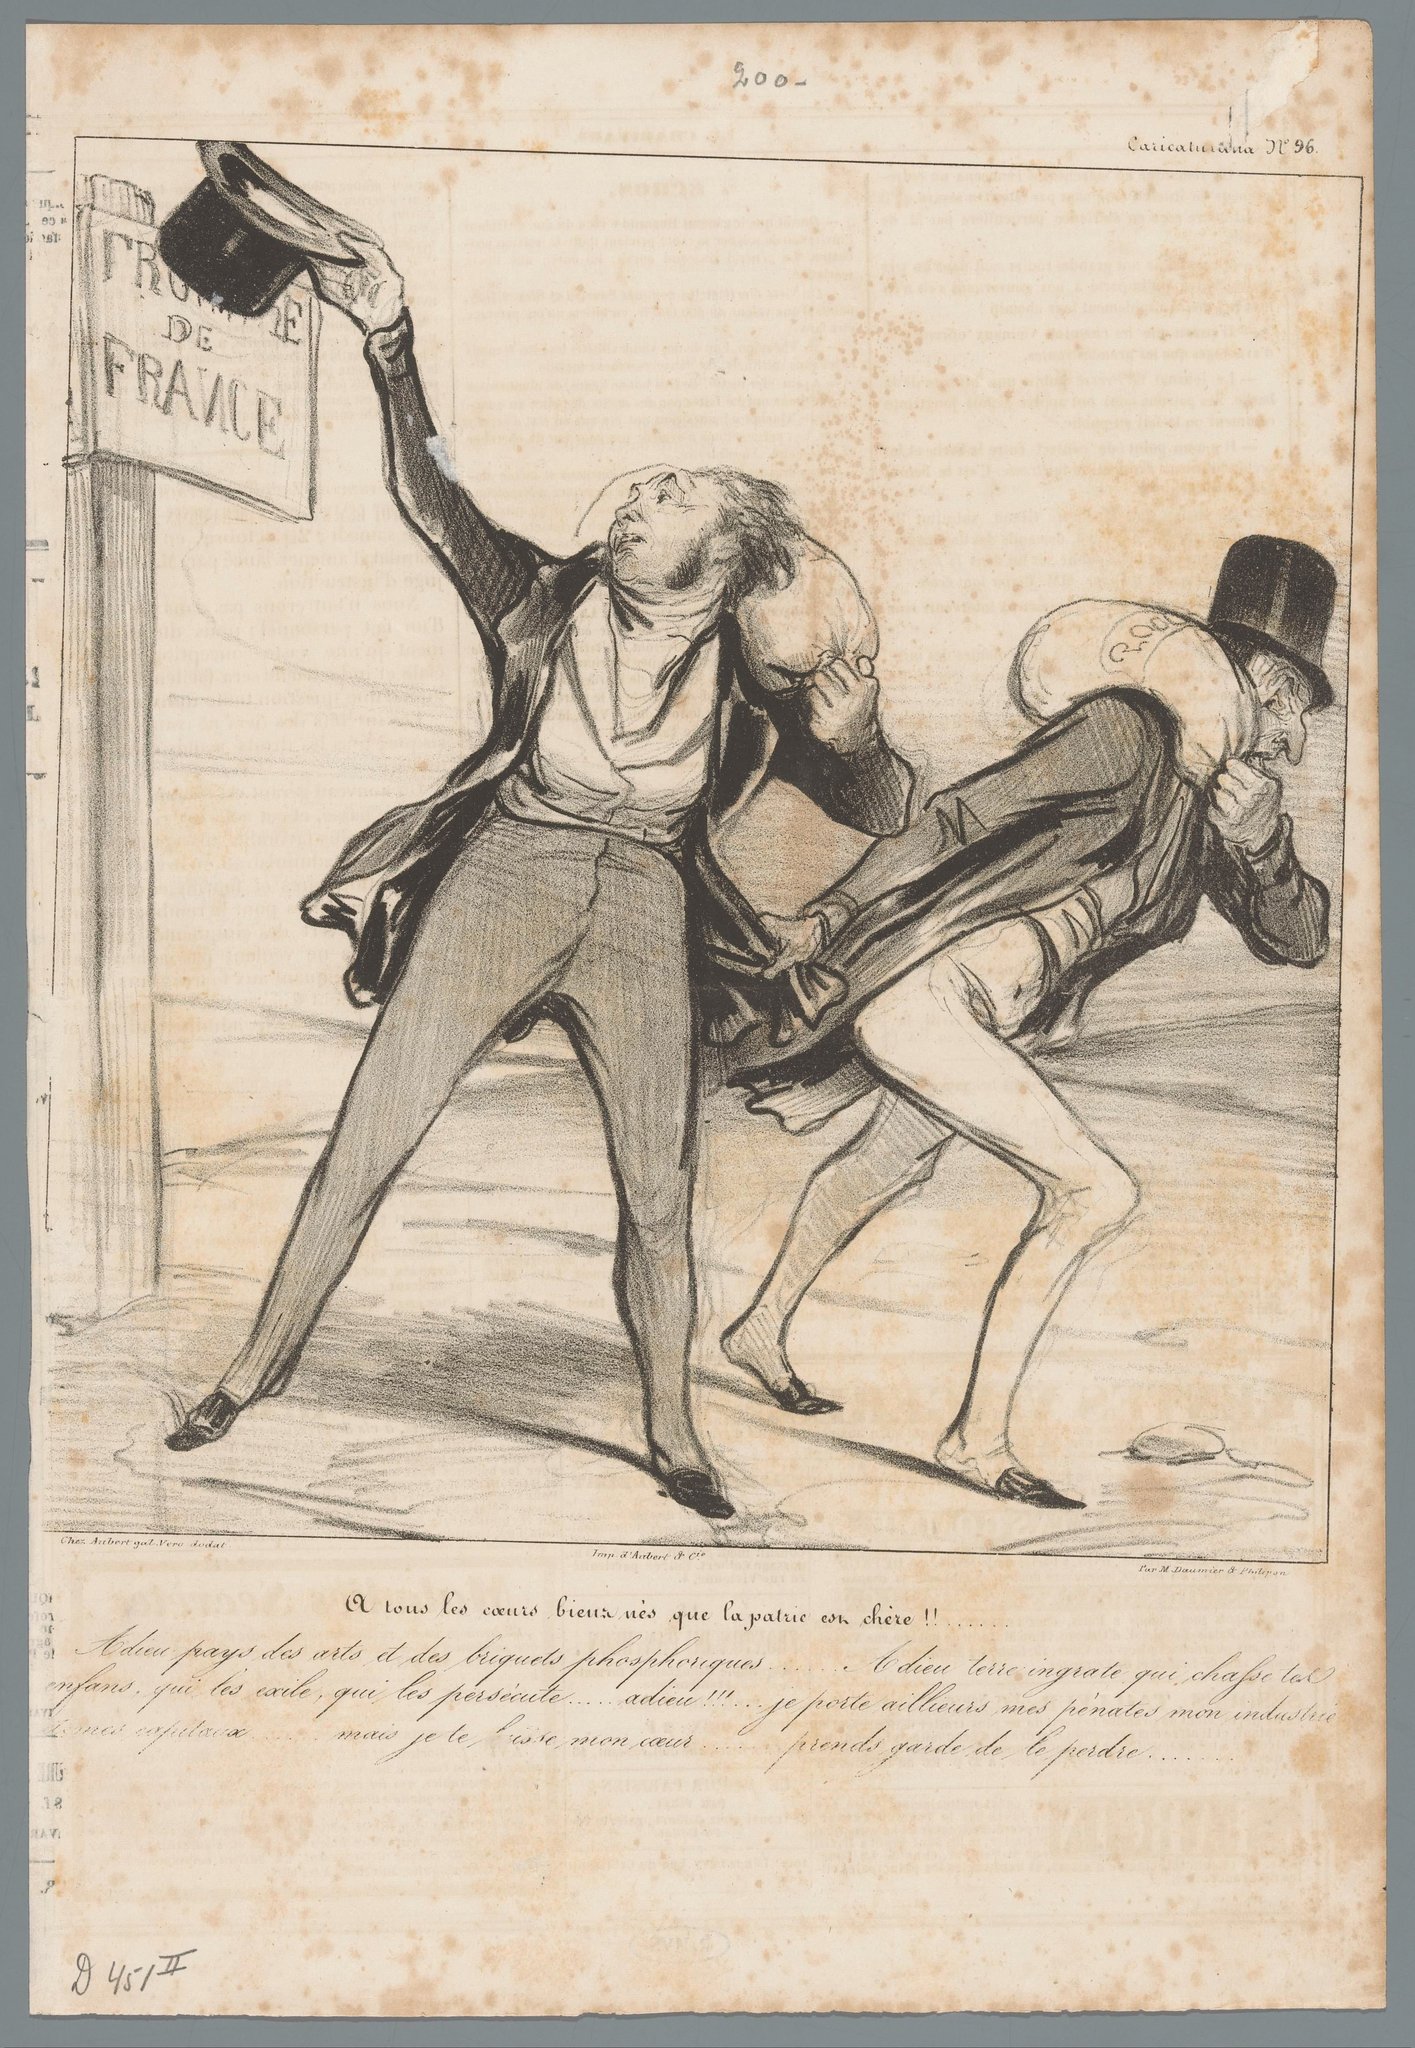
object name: cartoon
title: Karikaturen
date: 1838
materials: paper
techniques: letterpress printing, lithograph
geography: paris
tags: caricatures (human types), thief, boundary-post, boundary-stone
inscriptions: collector's mark: Lugt 2228a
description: Prent mogelijk uit: Le Charivari, 28 oktober 1838.